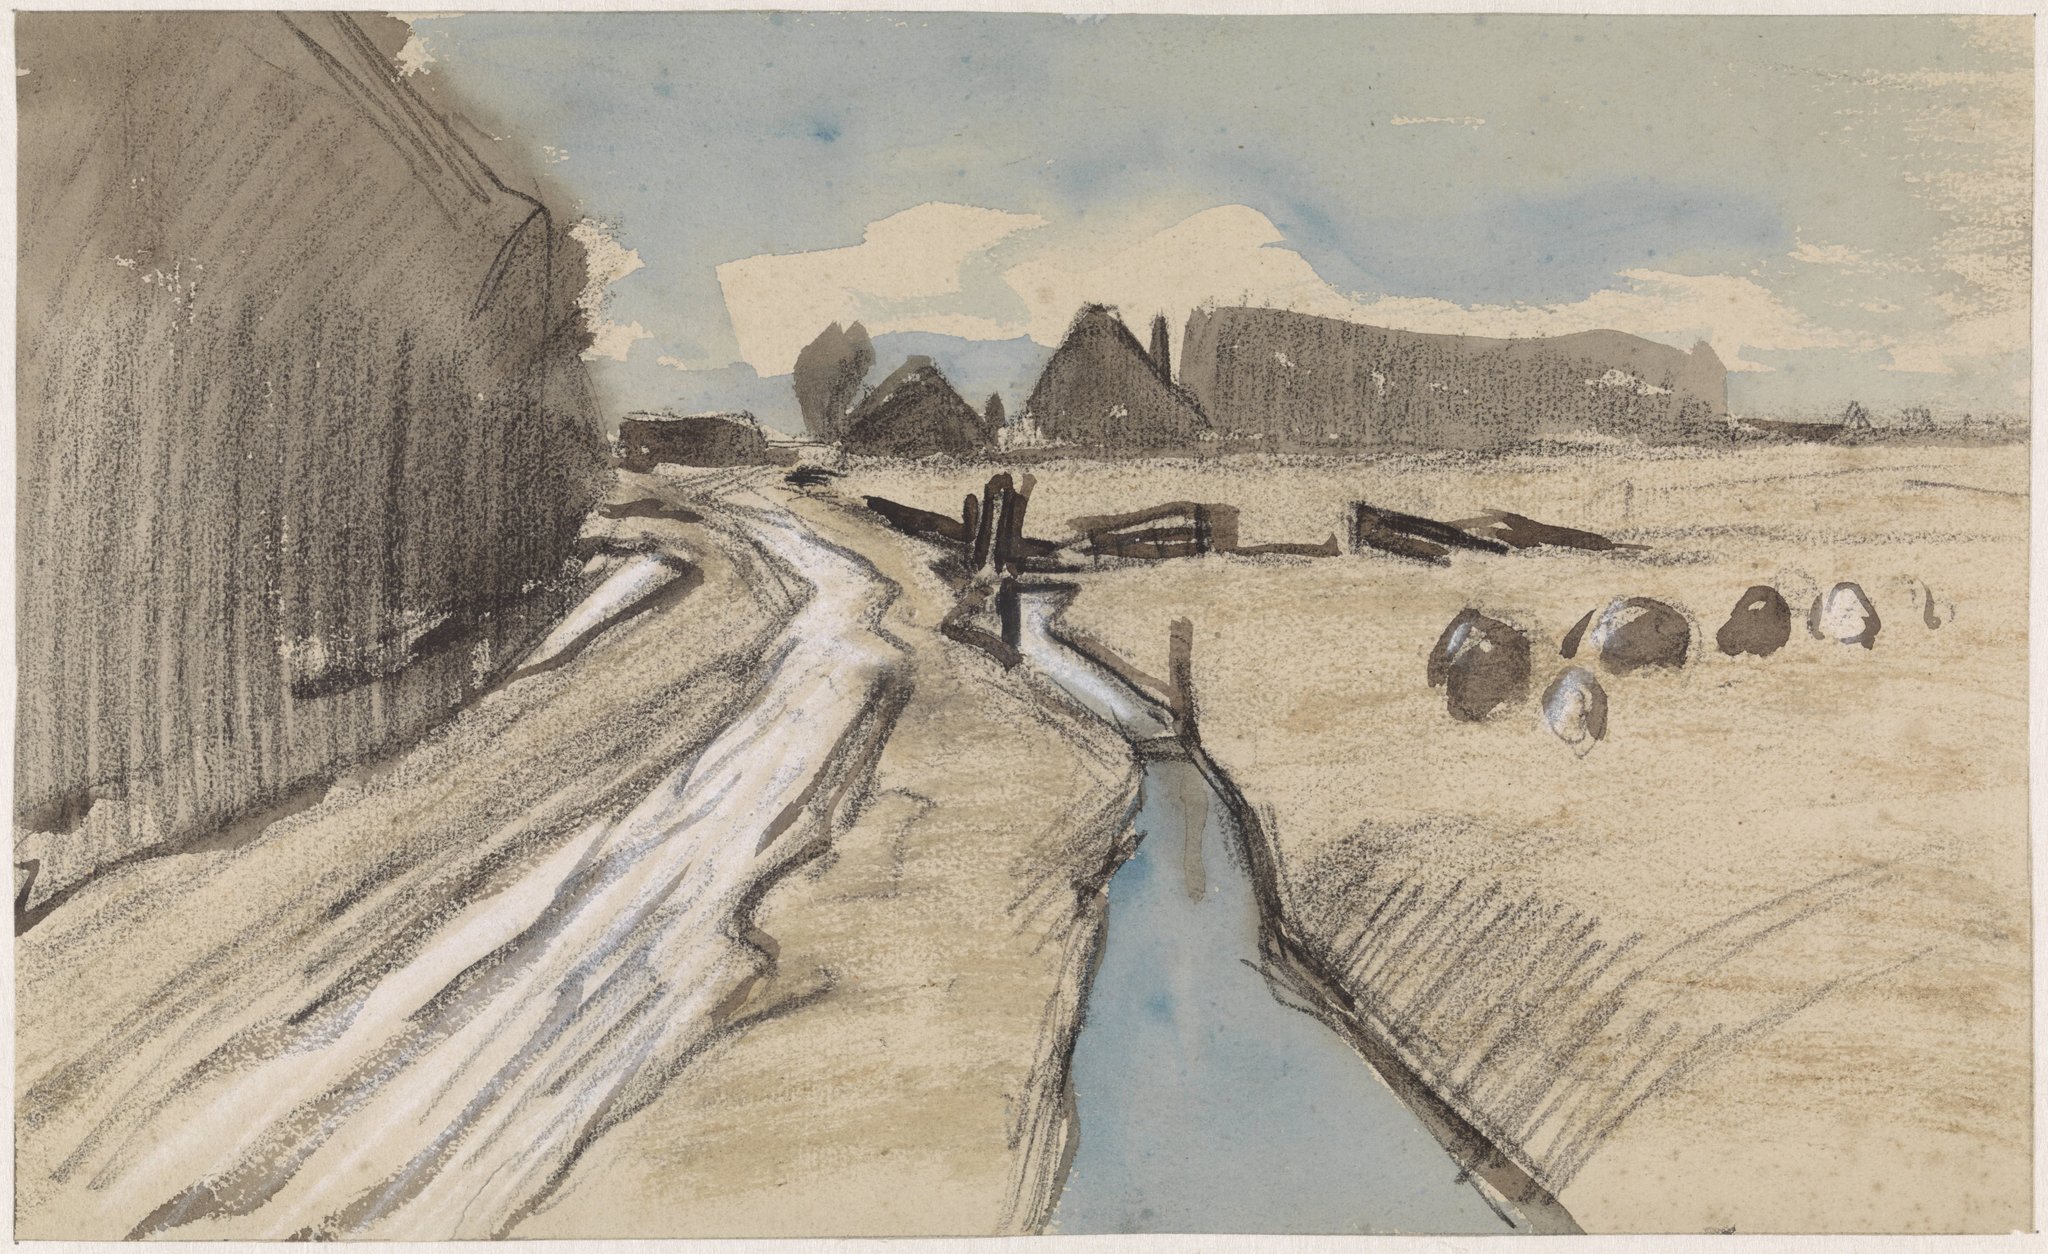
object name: drawing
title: Landschap met een weg langs een sloot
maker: jan van essen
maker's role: draughtsman, print maker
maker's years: 1854-1936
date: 1864-1936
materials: chalk, paper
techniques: brush